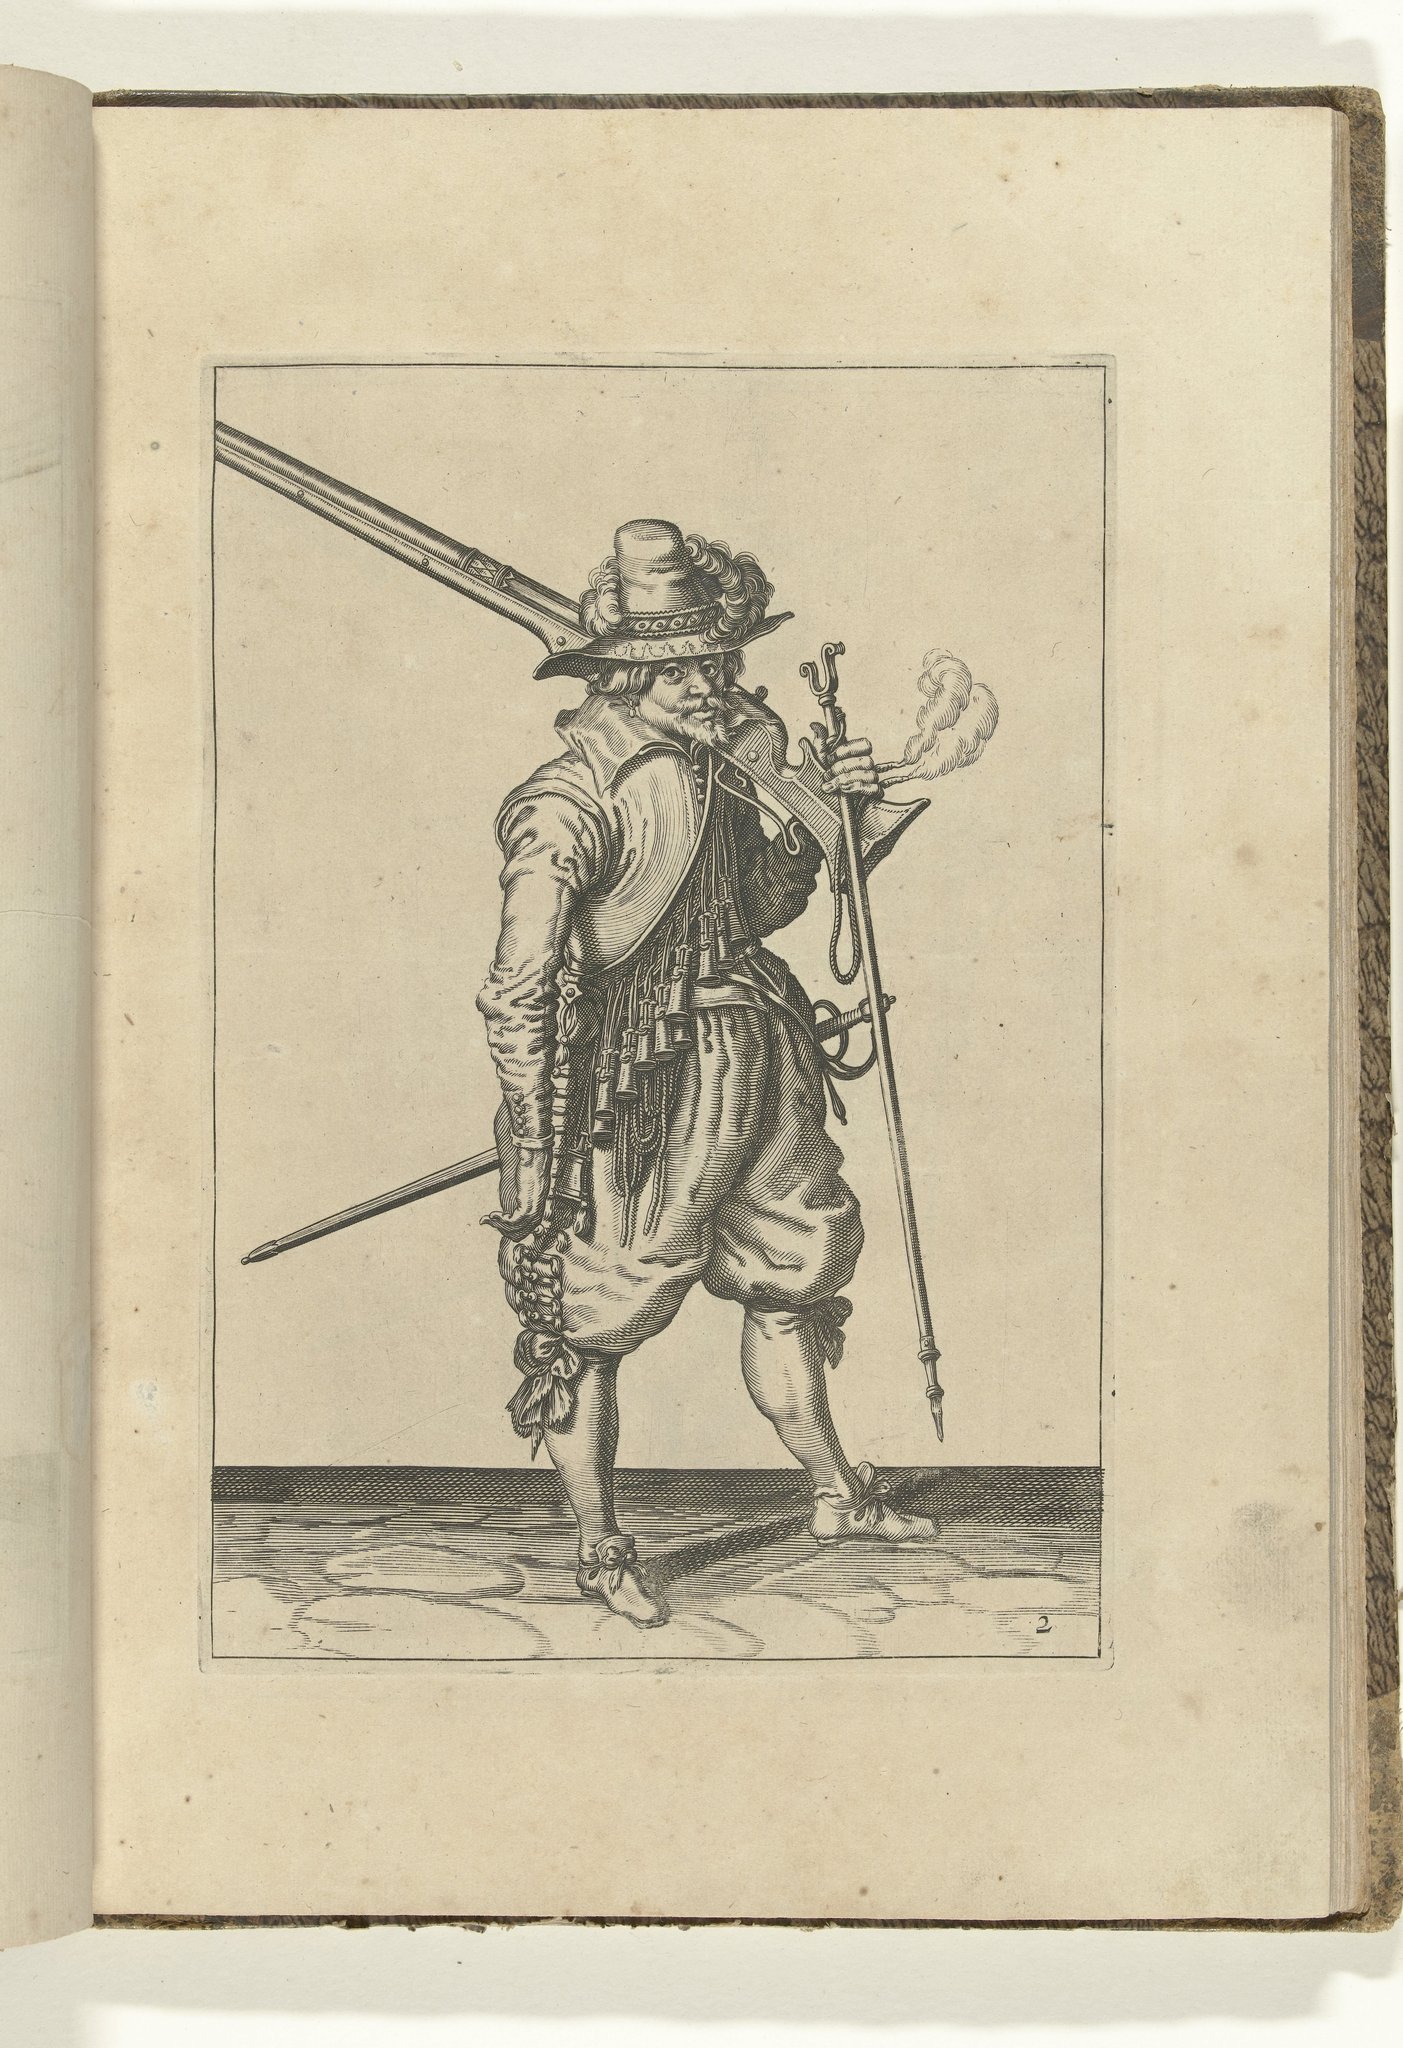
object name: print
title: Soldaat die zijn musket op zijn linkerschouder draagt en zijn furket in zijn linkerhand vasthoudt (nr. 2), ca. 1600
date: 1597-1608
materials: paper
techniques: engraving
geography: northern netherlands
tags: the hague, maurice (prince of orange), handling of weapons ~ military training, weapons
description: Een soldaat, ten voeten uit, naar rechts, met een musket (een bepaald type vuurwapen) steunend op zijn linkerschouder (nr. 2), ca. 1600. In zijn linkerhand behalve de kolf van het musket ook een furket (musketvork) en een brandende lont. Plaat 2 in de instructies voor het hanteren van het musket: Brief enseignement, sur les pourtraitz figurez, touchant le droit maniement du Mousquet. Onderdeel van de illustraties in een Franse editie van J. de Gheyns Wapenhandelinghe: J. de Gheyn, Maniement d'armes, d'arquebuses, mousquetz et piques : en conformité de l'ordre de Mour le Prince Maurice, Prince d'Orange, Amsterdam 1608. Krijgswezen rond 1600.